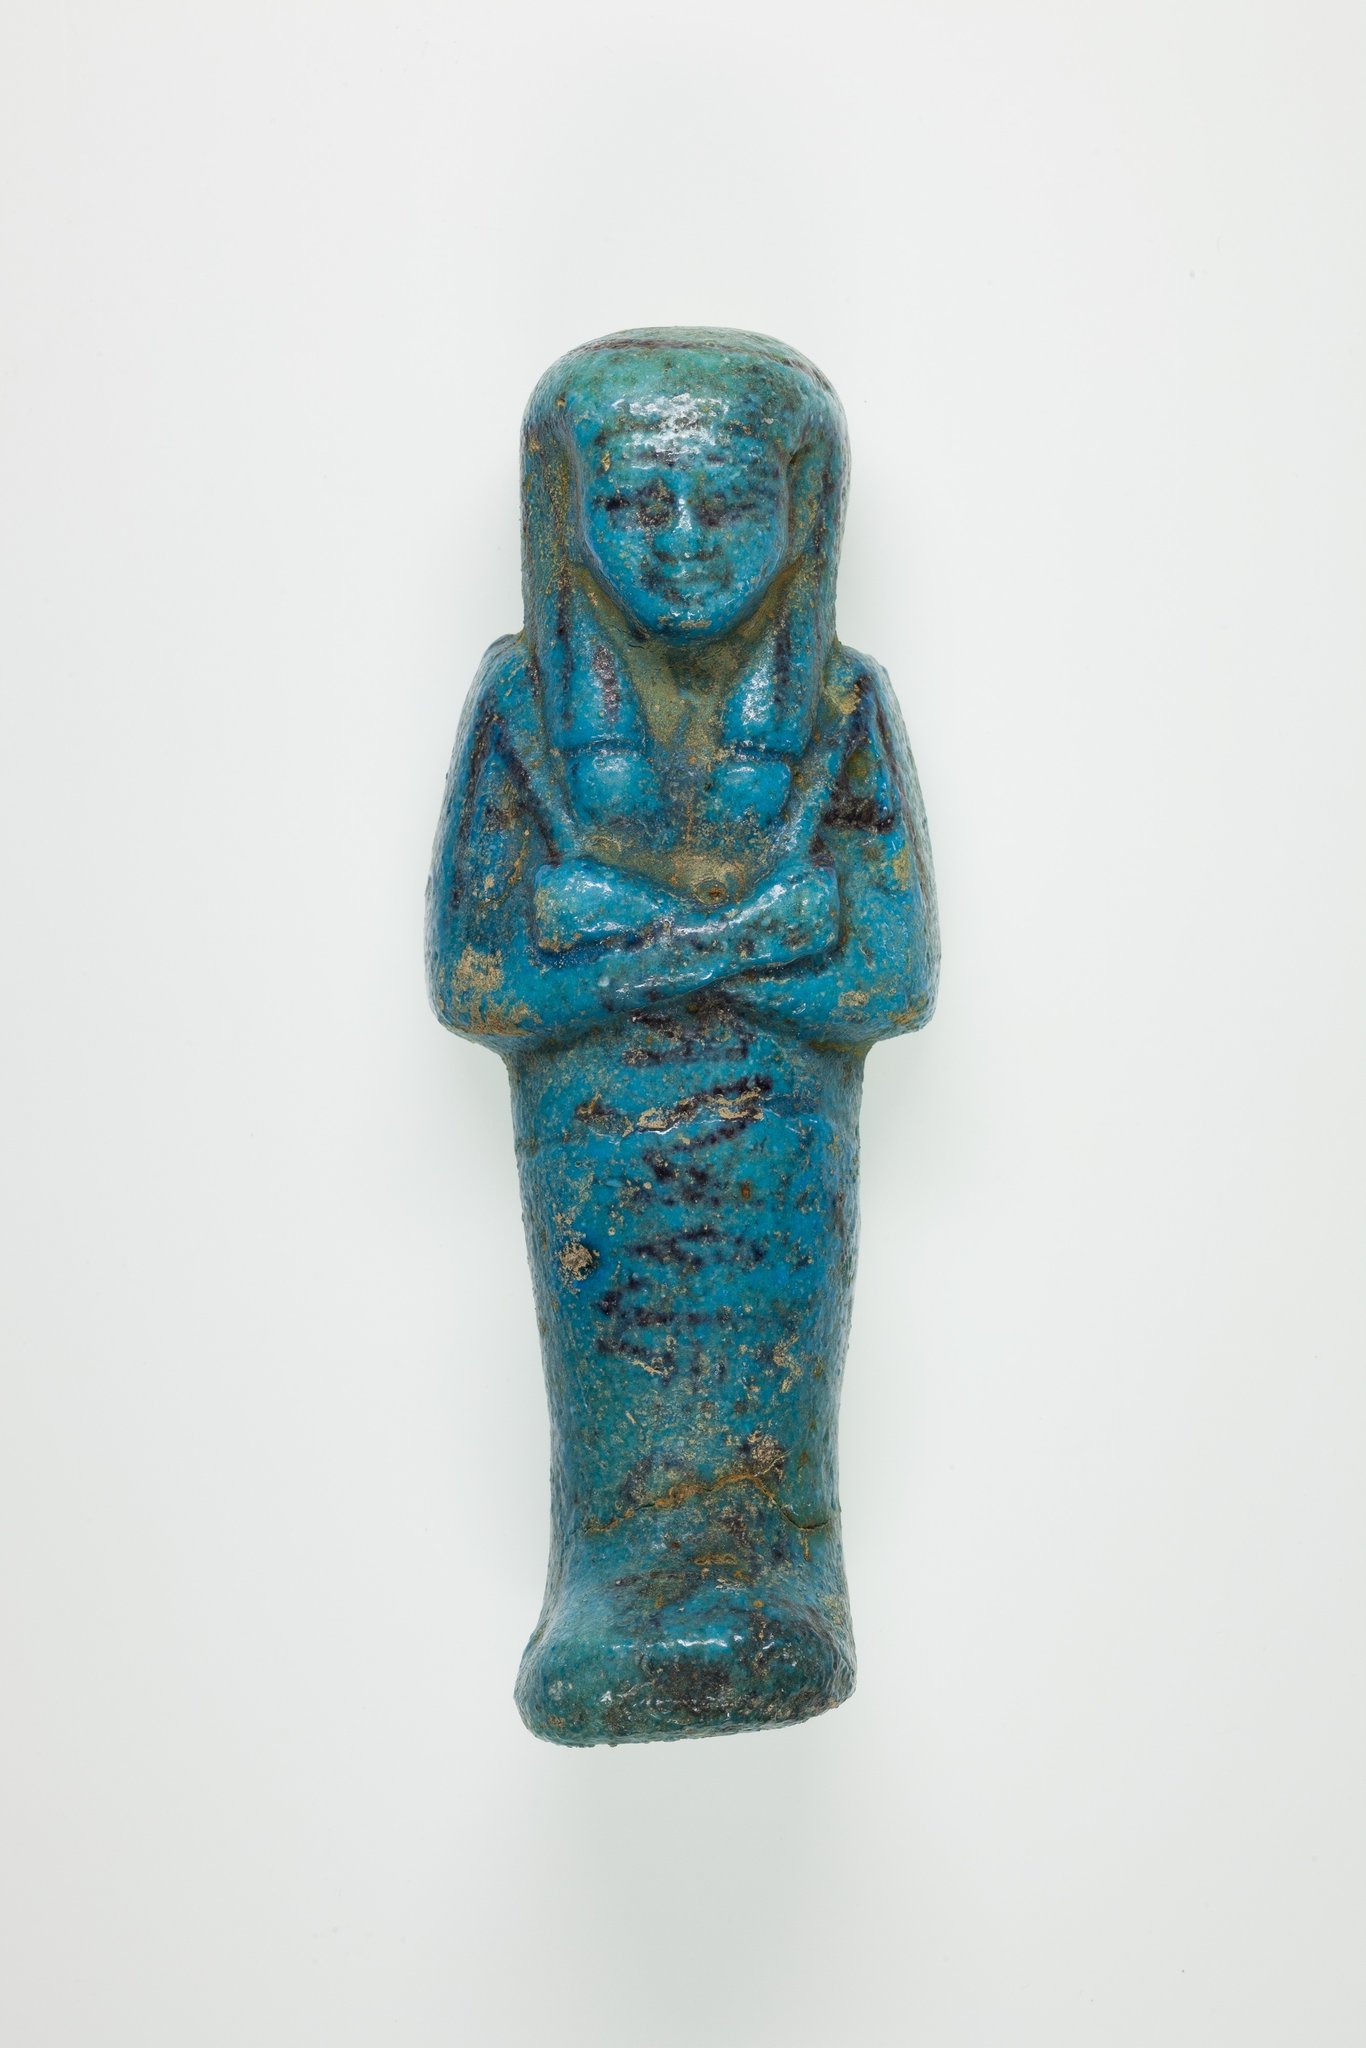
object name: shabti, henettawy c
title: Worker Shabti of Henettawy (C), Daughter of Isetemkheb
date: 990-970 BCE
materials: faience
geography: egypt